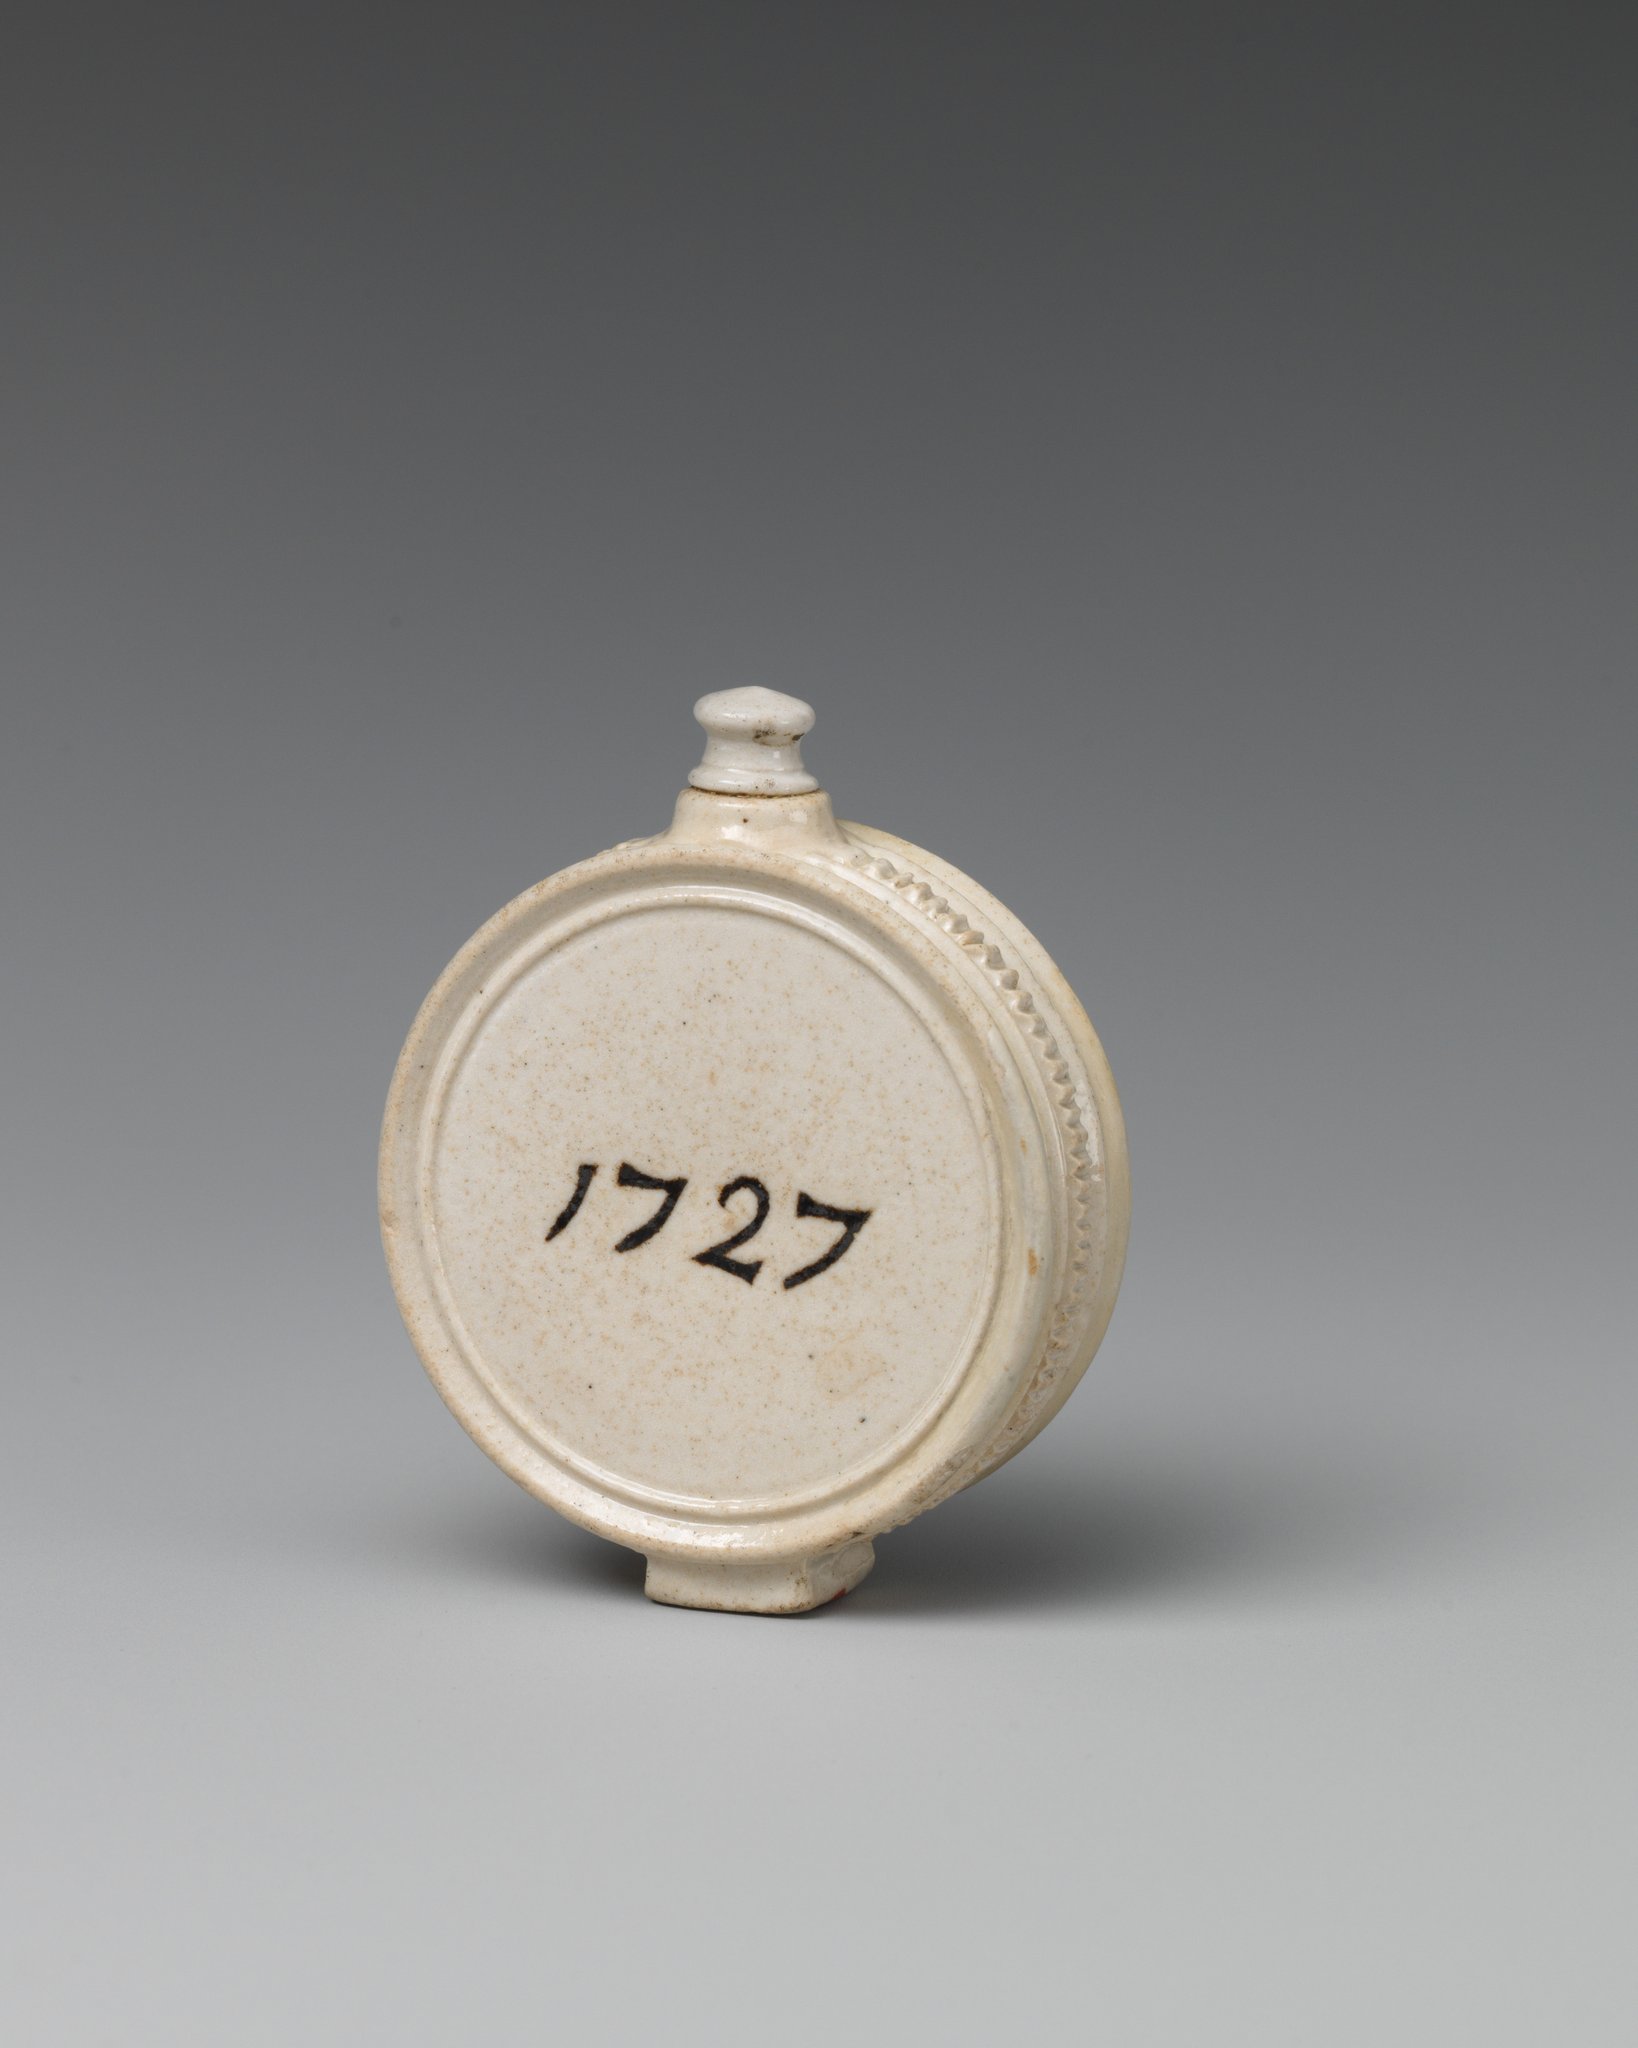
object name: pilgrim bottle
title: Miniature pilgrim bottle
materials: stoneware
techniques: salt glaze